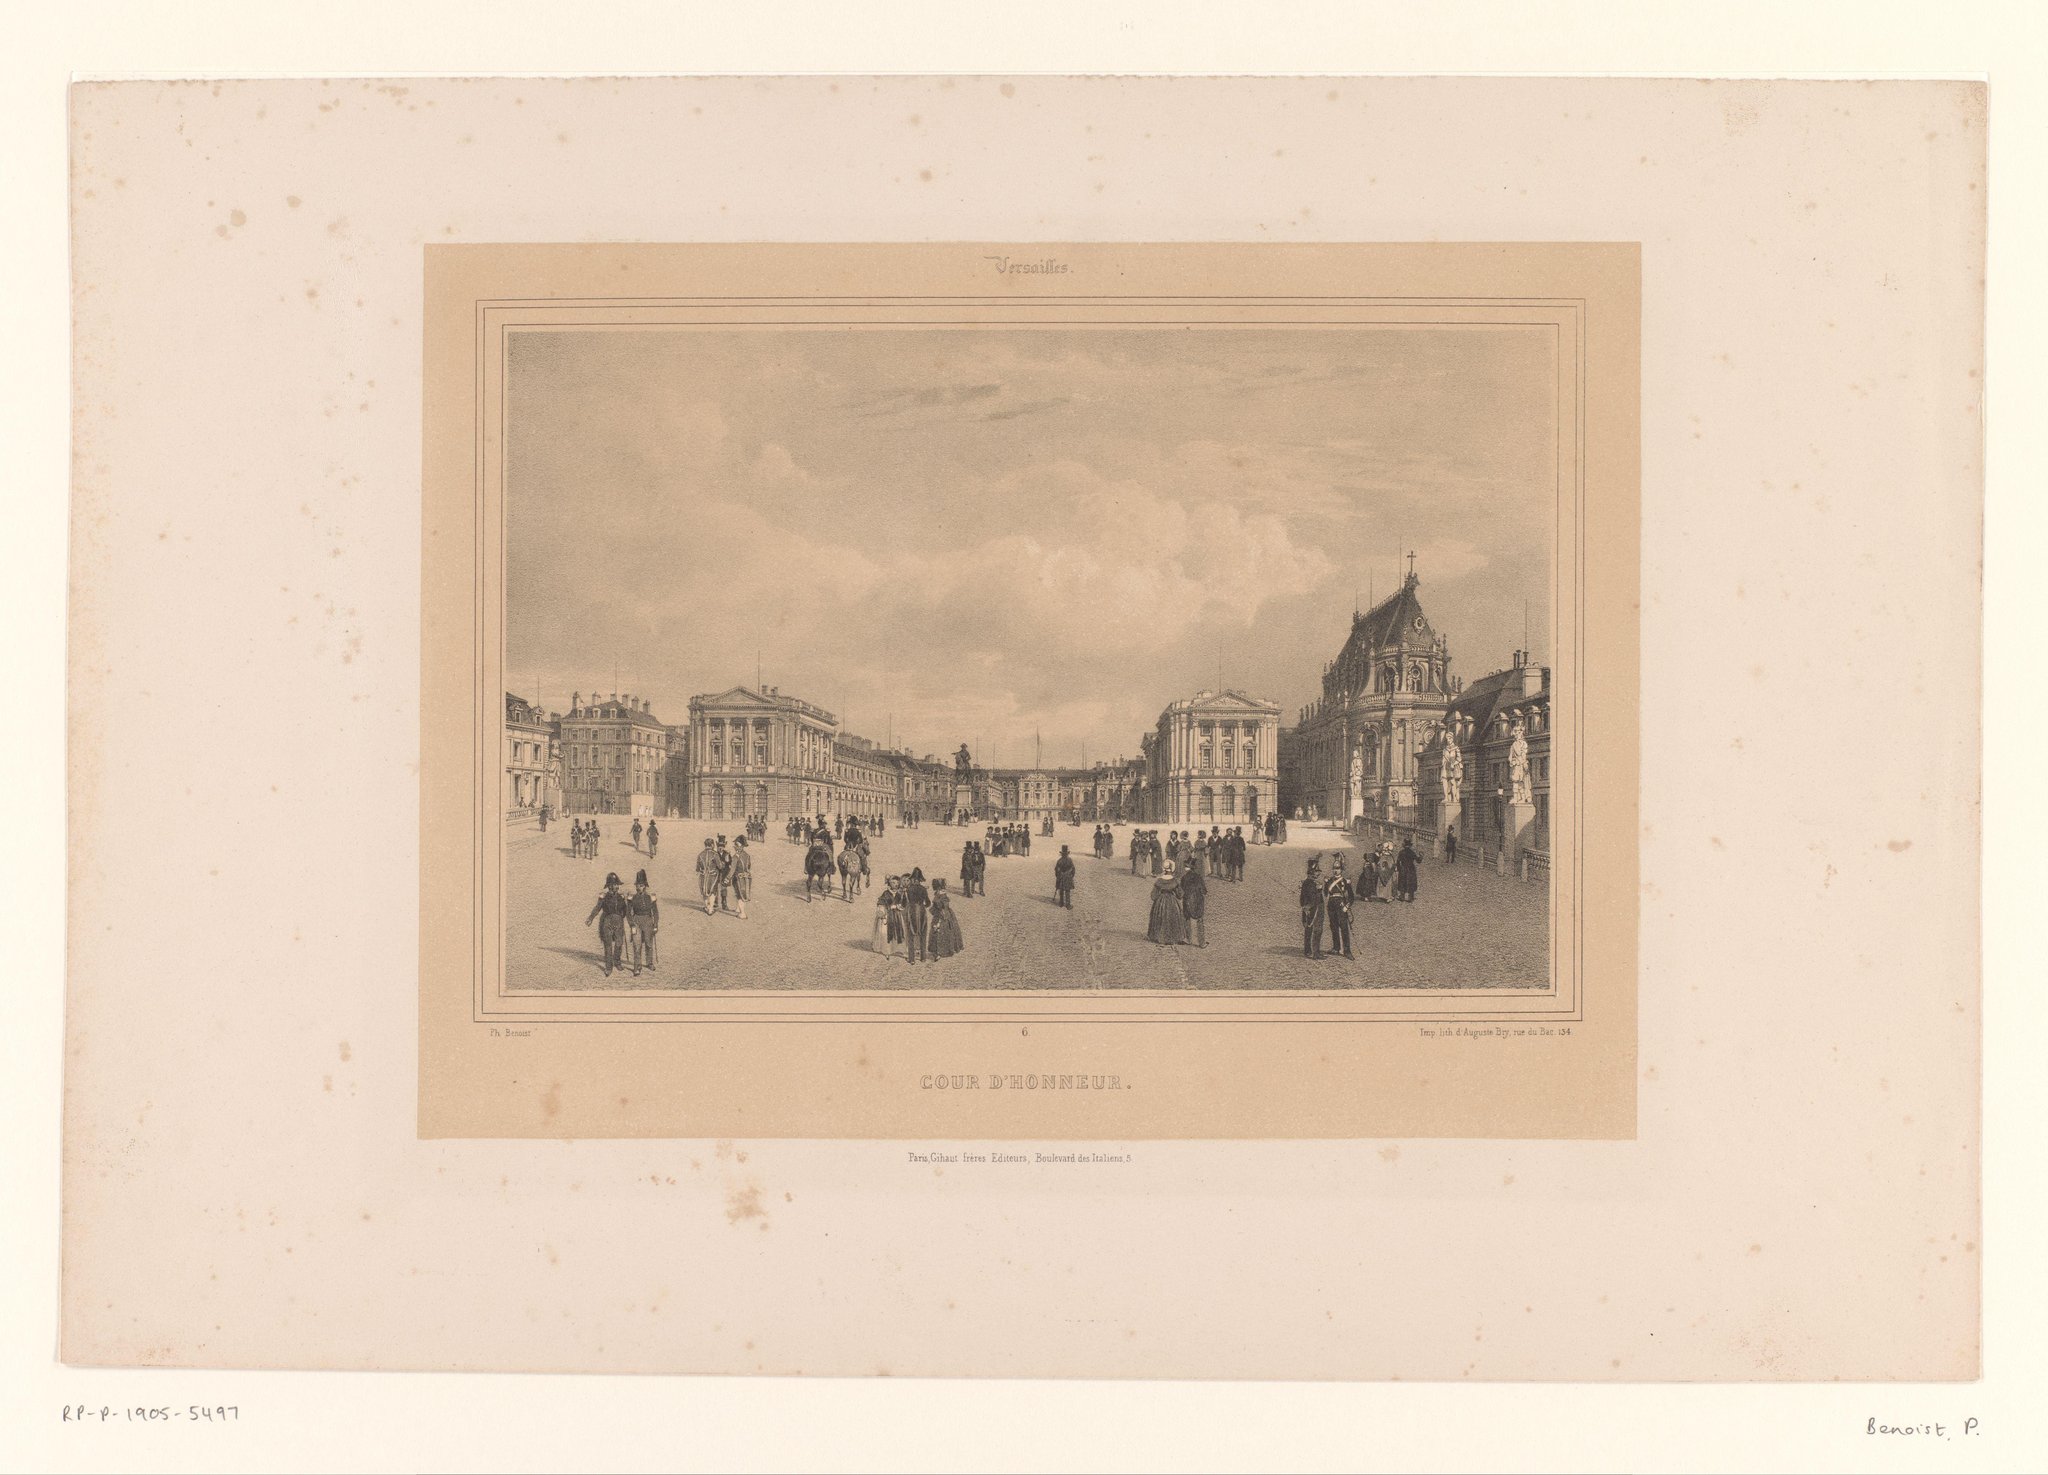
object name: print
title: Zicht op de Cour d'Honneur van het Kasteel van Versailles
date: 1843-1844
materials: paper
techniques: tone lithography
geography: paris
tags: palace, courtyard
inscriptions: collector's mark: Lugt 2228a